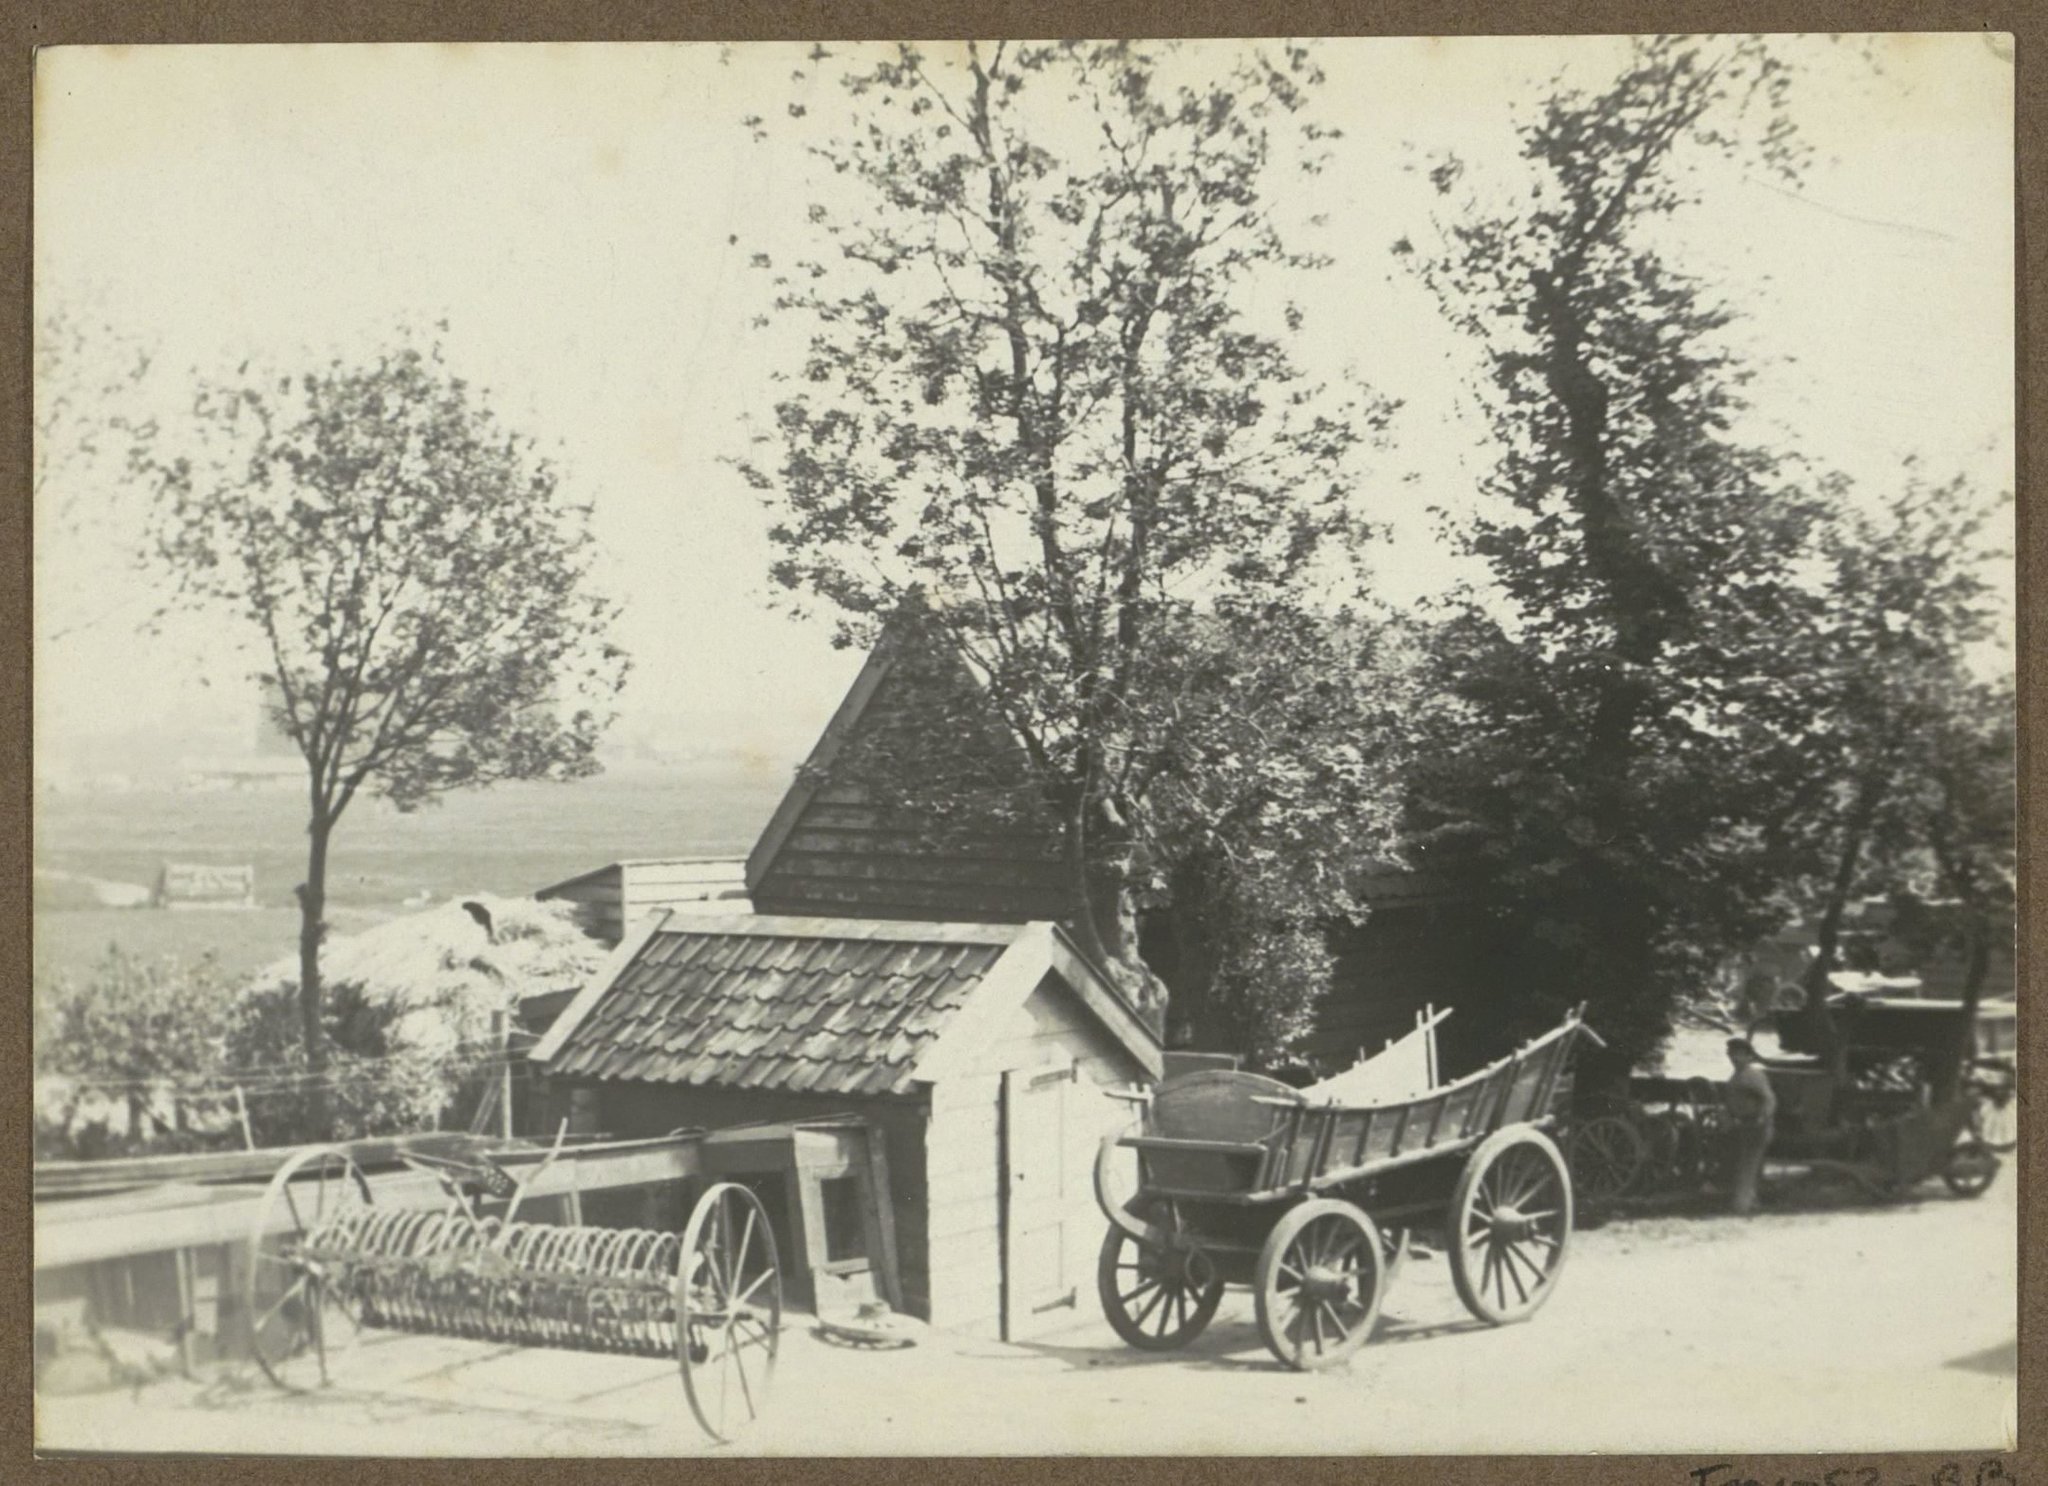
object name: photograph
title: Boerderij met een kar en een landbouwmachine te Sloterdijk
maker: Anonymous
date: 1910-1930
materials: paper, photographic support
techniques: gelatin silver print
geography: sloterdijk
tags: farm or solitary house in landscape, (farm) wagon, freight wagon, cart, farm (building), sloterdijk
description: Onderdeel van Album met foto's van Amsterdam en omgeving.